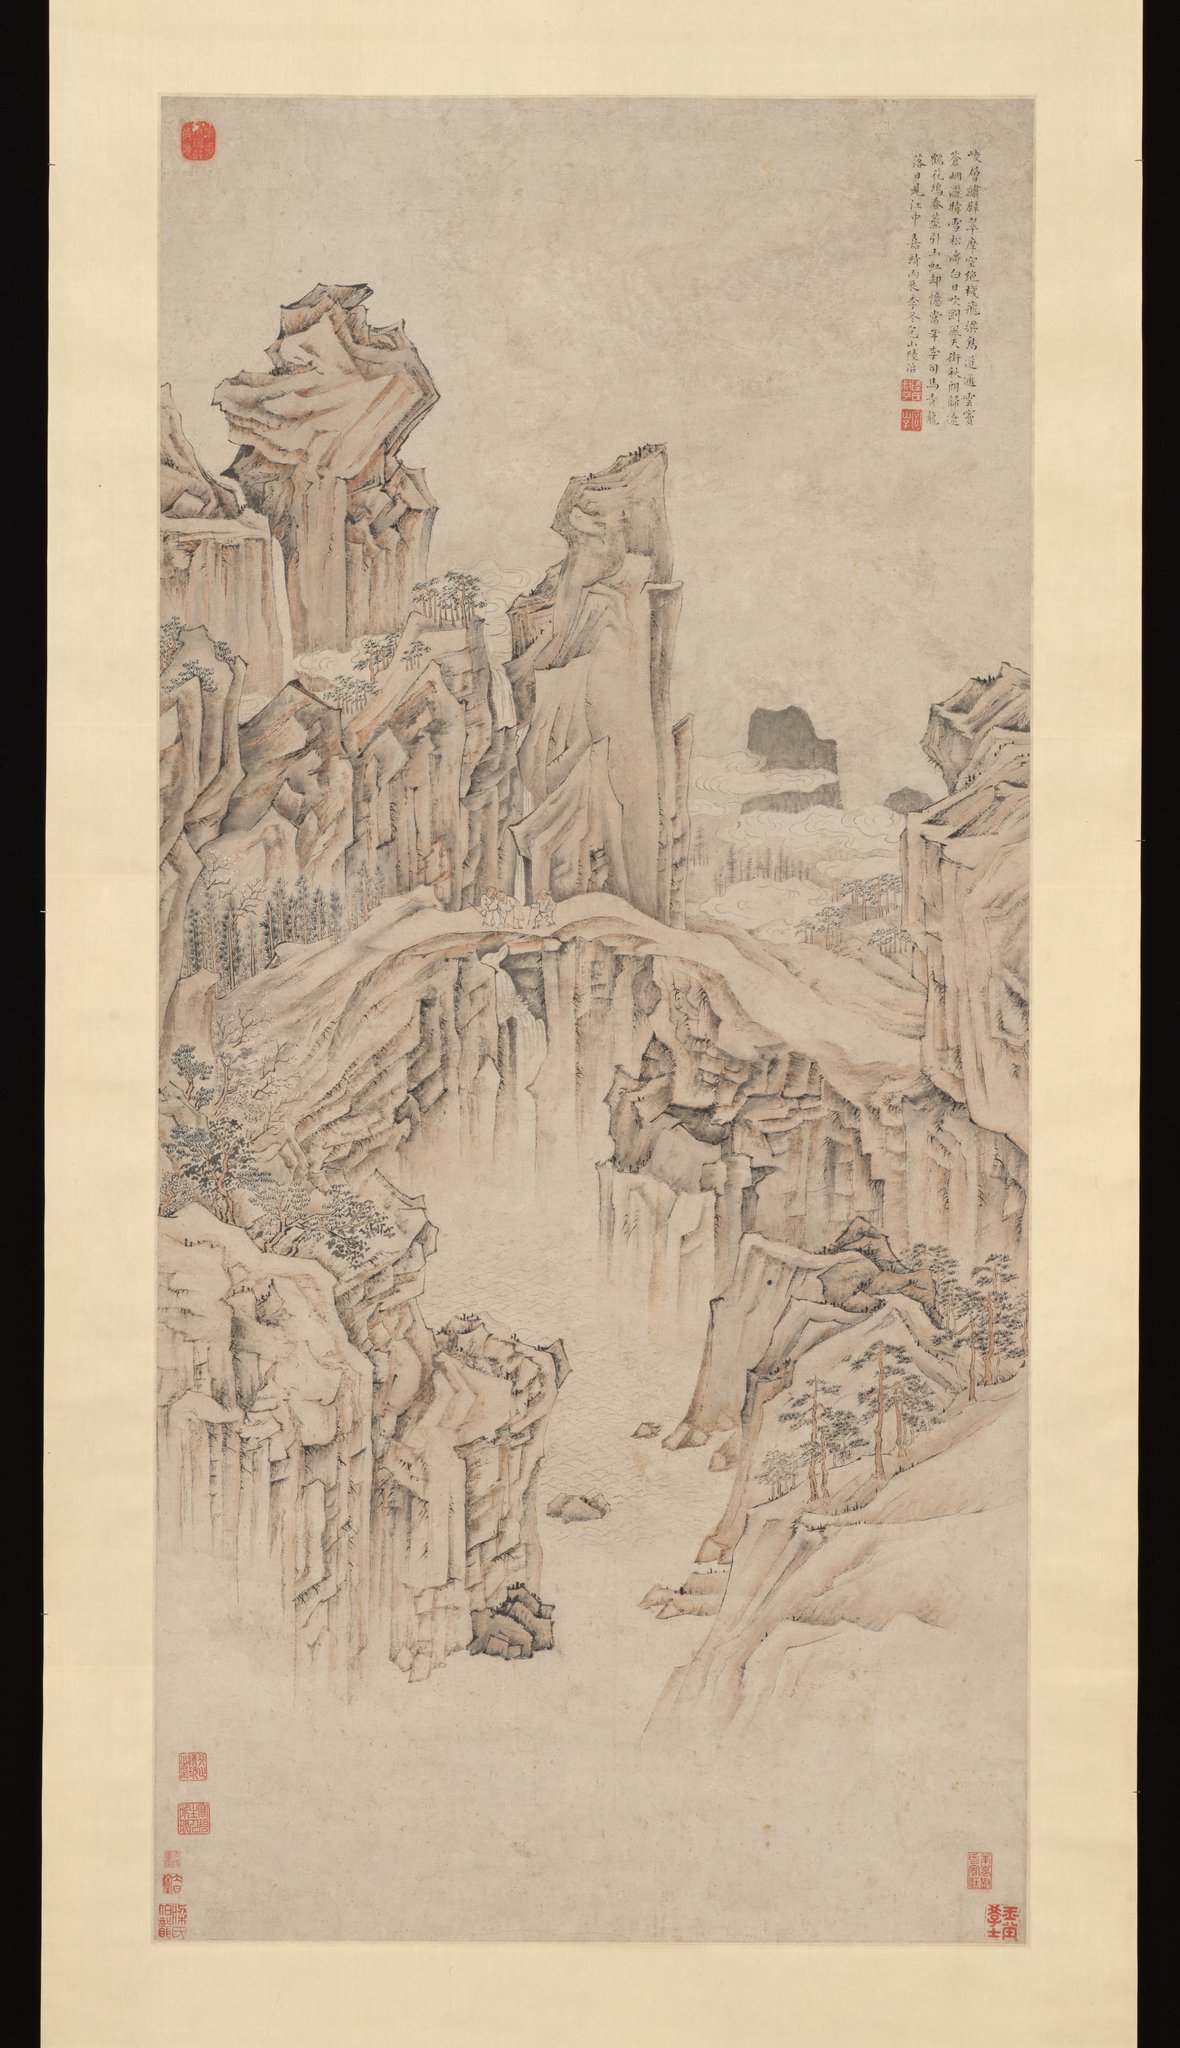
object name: hanging scroll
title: Natural Rock Bridge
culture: chinese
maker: lu zhi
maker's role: artist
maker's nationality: chinese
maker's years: 1495-1576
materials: ink, paper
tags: bridges,landscapes